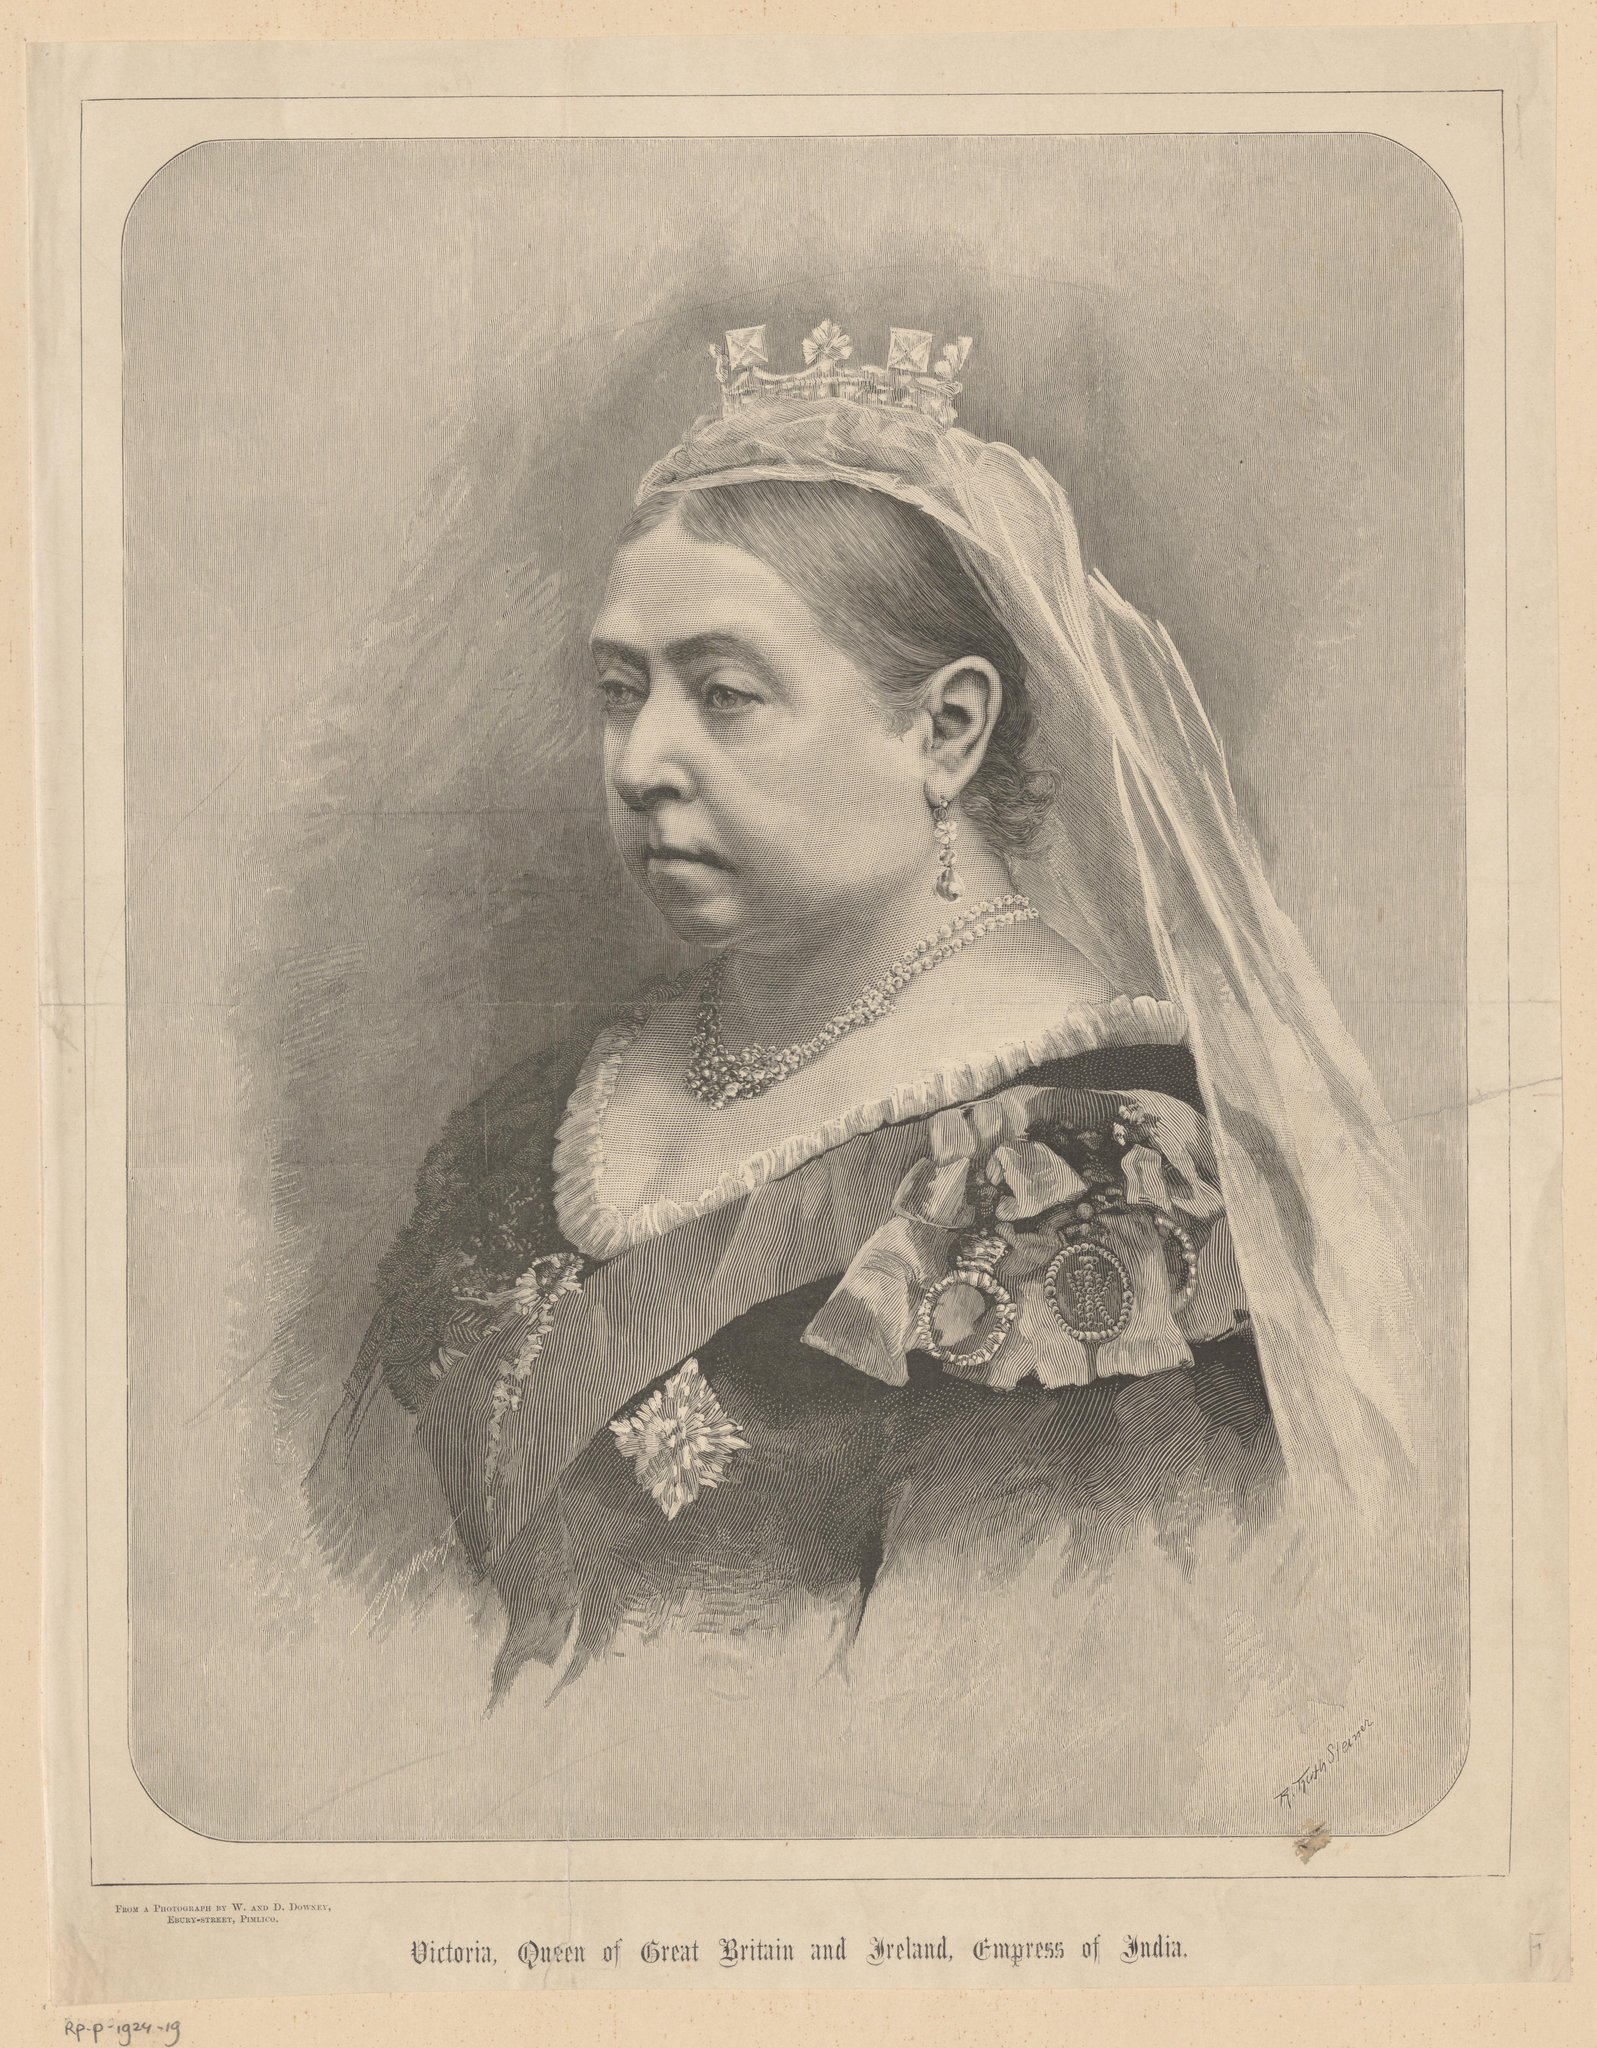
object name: print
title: Portret van Victoria, koningin van Engeland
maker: rudolf huthsteiner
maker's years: 1855-1935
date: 1877-1924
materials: paper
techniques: engraving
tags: victoria (koningin van het verenigd koninkrijk en keizerin van india), historical persons, queen, old woman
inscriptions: collector's mark: Lugt 2233